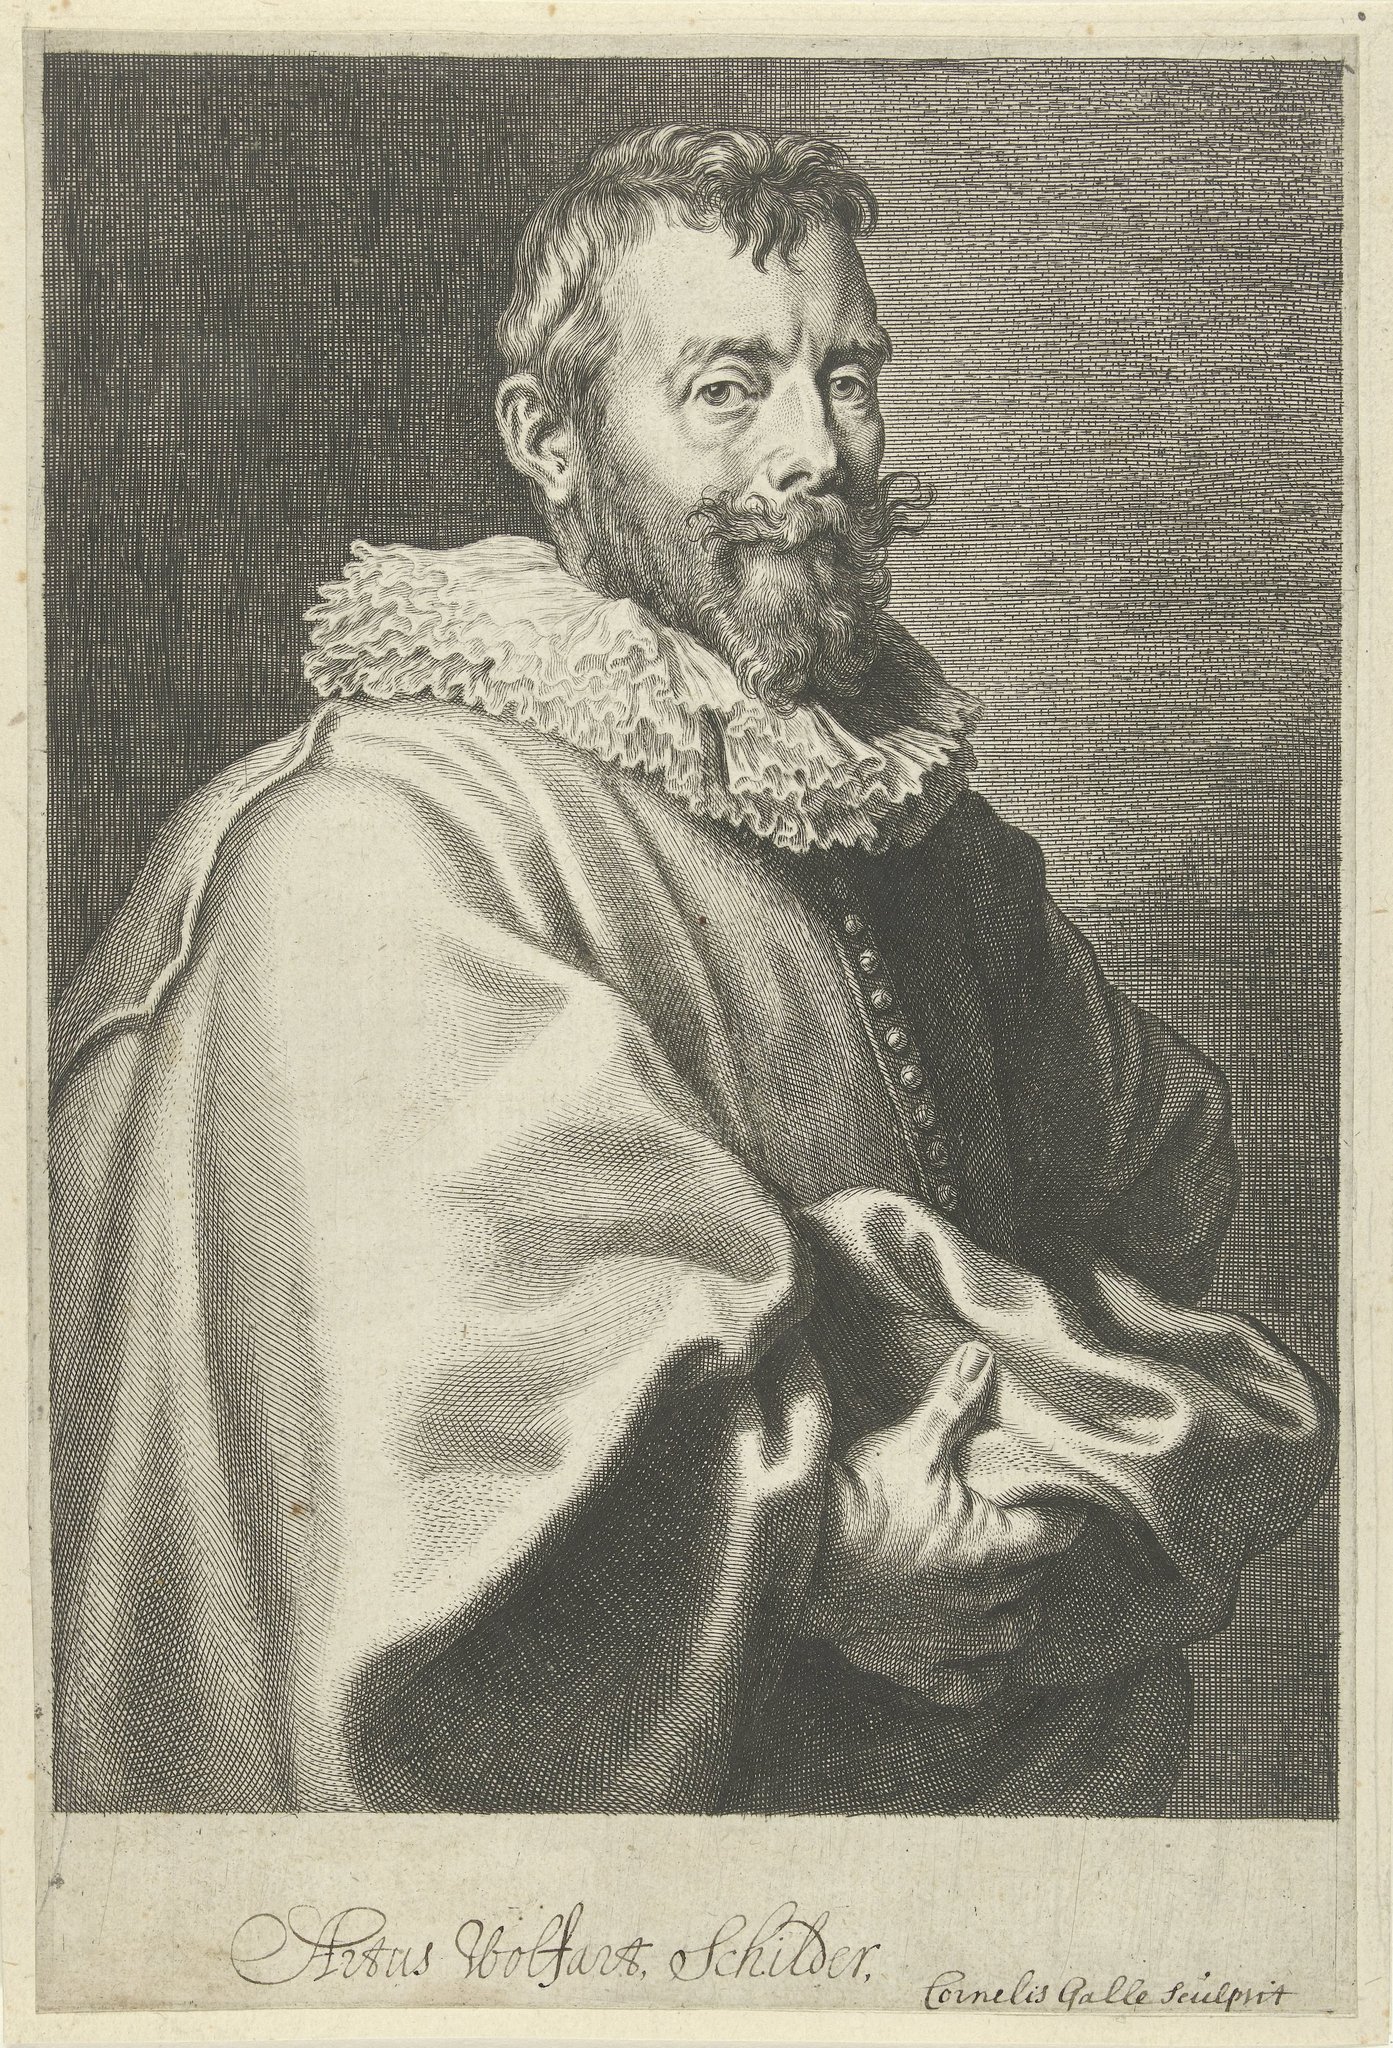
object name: print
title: Portret van de schilder Artus Wolfaerts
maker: cornelis galle (i)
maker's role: print maker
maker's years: 1576-1650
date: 1616-1641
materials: paper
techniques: engraving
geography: southern netherlands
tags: antwerp, painter, portrait, self-portrait of painter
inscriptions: collector's mark: Lugt 240